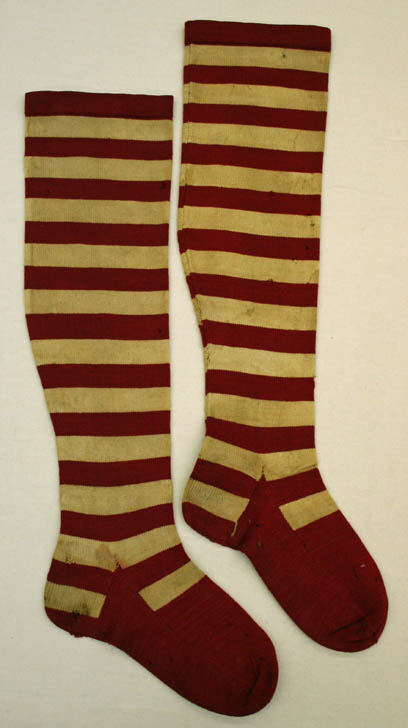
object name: stocking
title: Stockings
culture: american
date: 1850